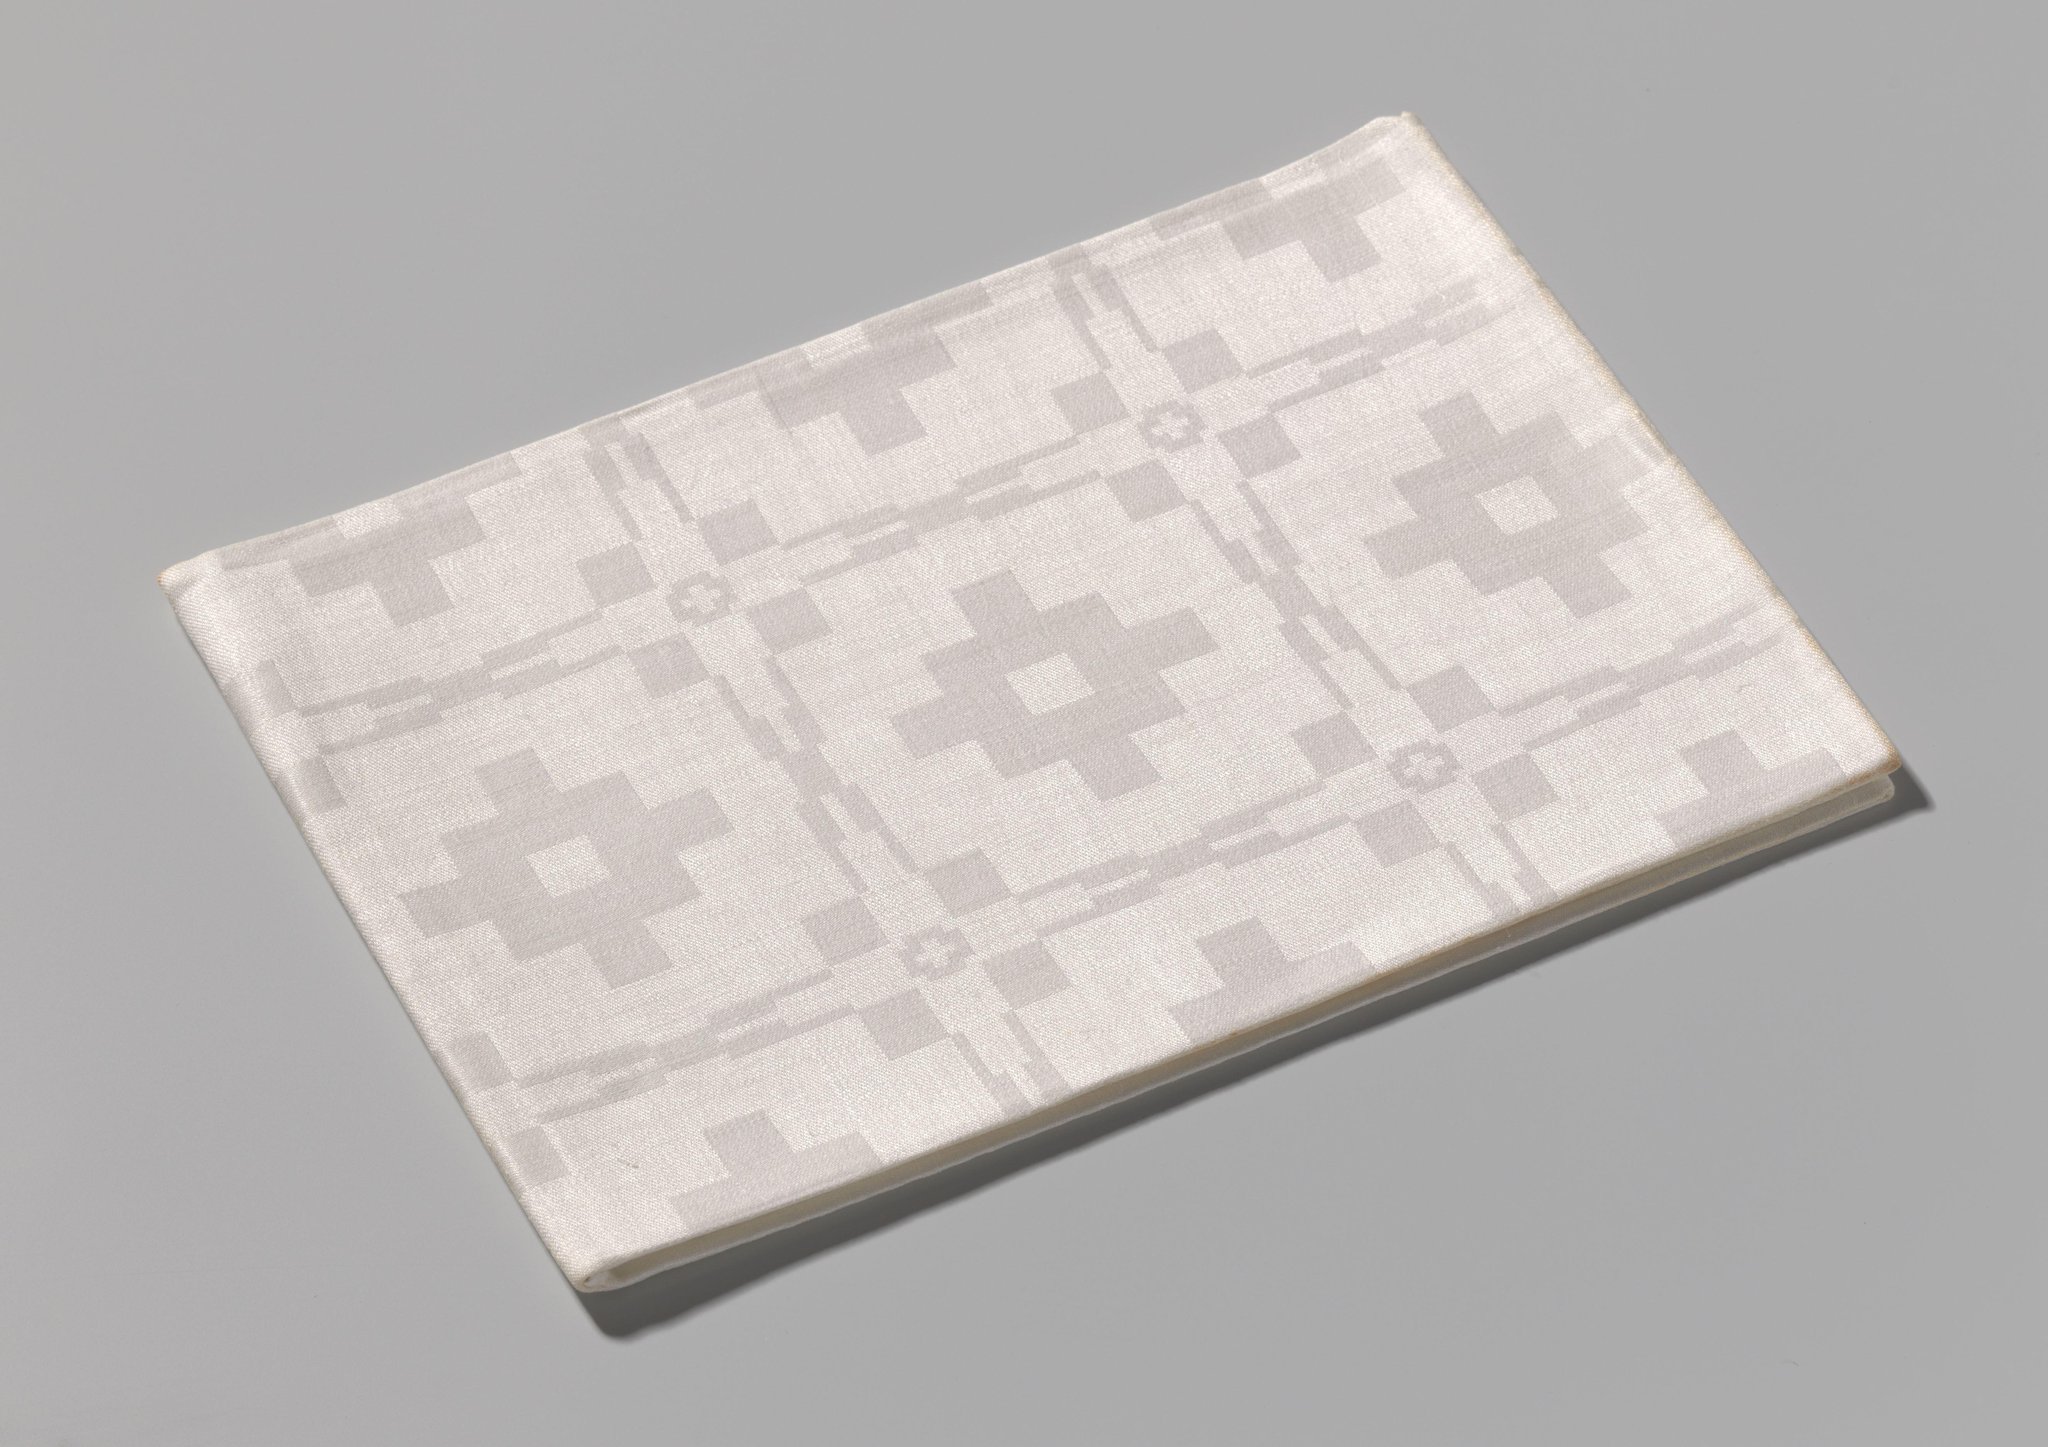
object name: napkin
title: Servet van linnen met pellenpatroon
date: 1800-1899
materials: linen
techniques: peeled fabric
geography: netherlands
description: wit linnen servet met pellen patroon 'uitgehouwen steen of hoekster' en randen WH 2oonl